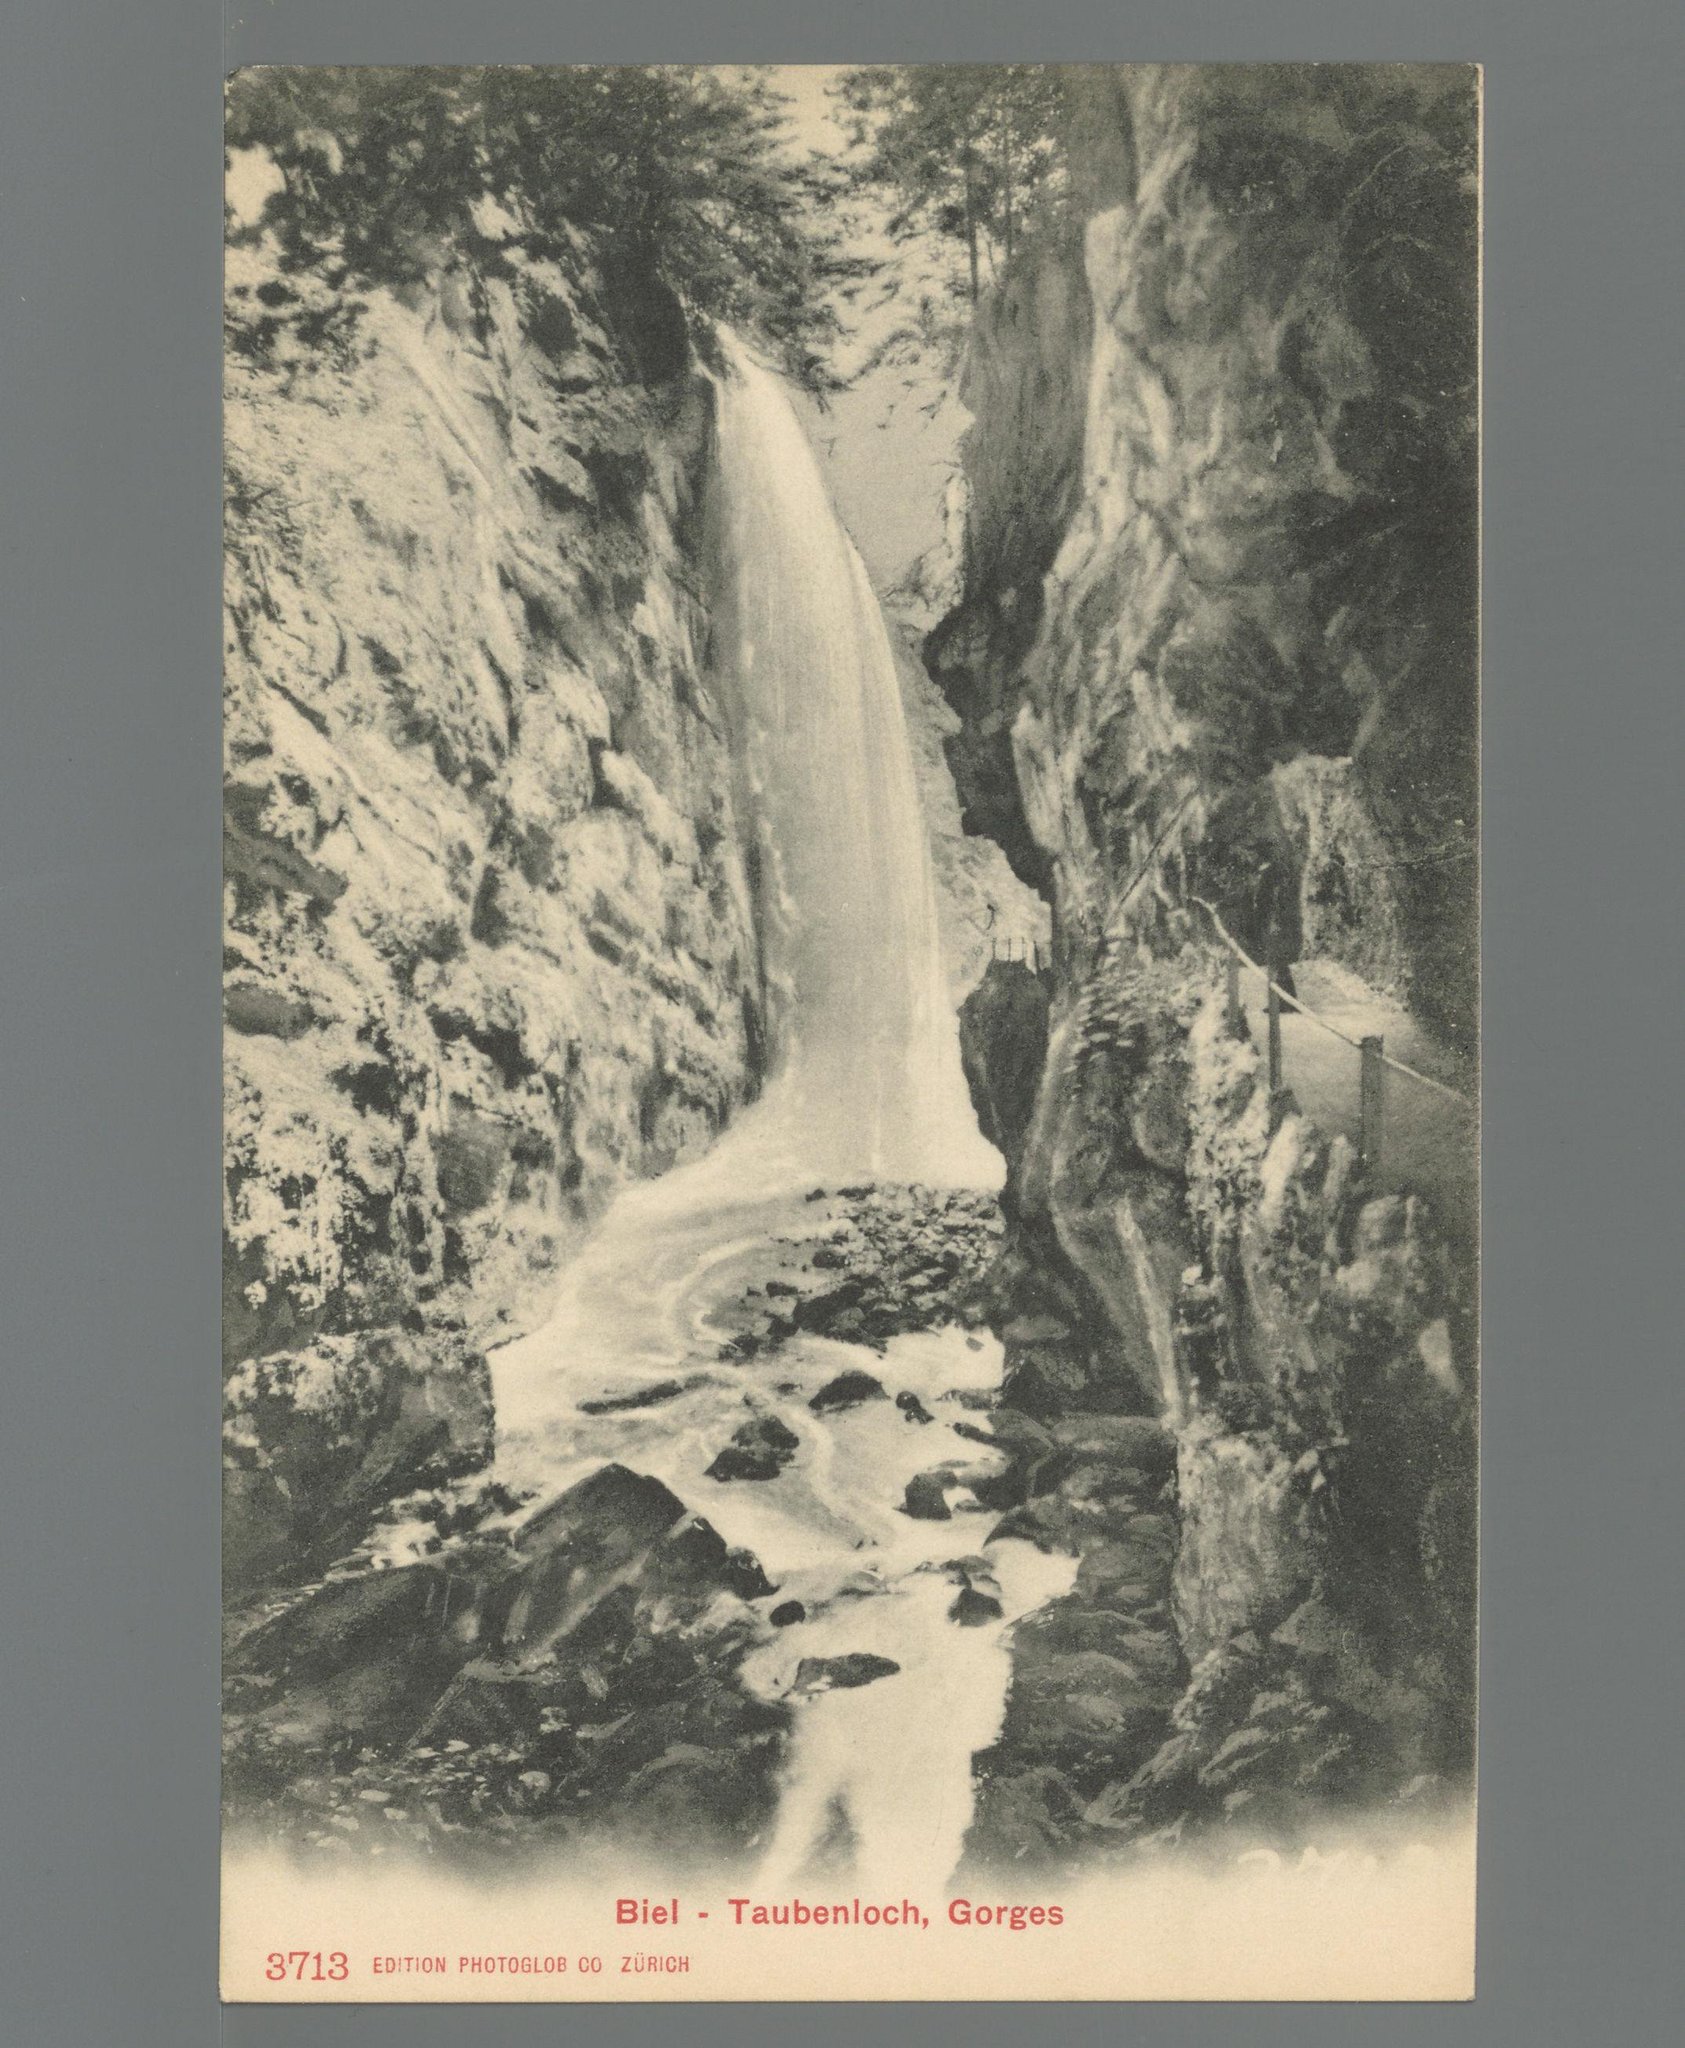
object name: photomechanical print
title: Biel. Taubenloch, Gorges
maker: Anonymous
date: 1895-1905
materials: cardboard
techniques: photograph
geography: zurich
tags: waterfall, ravine, chasm, abyss, canyon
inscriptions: stamp: ‘Taubenloch. Bözingen’